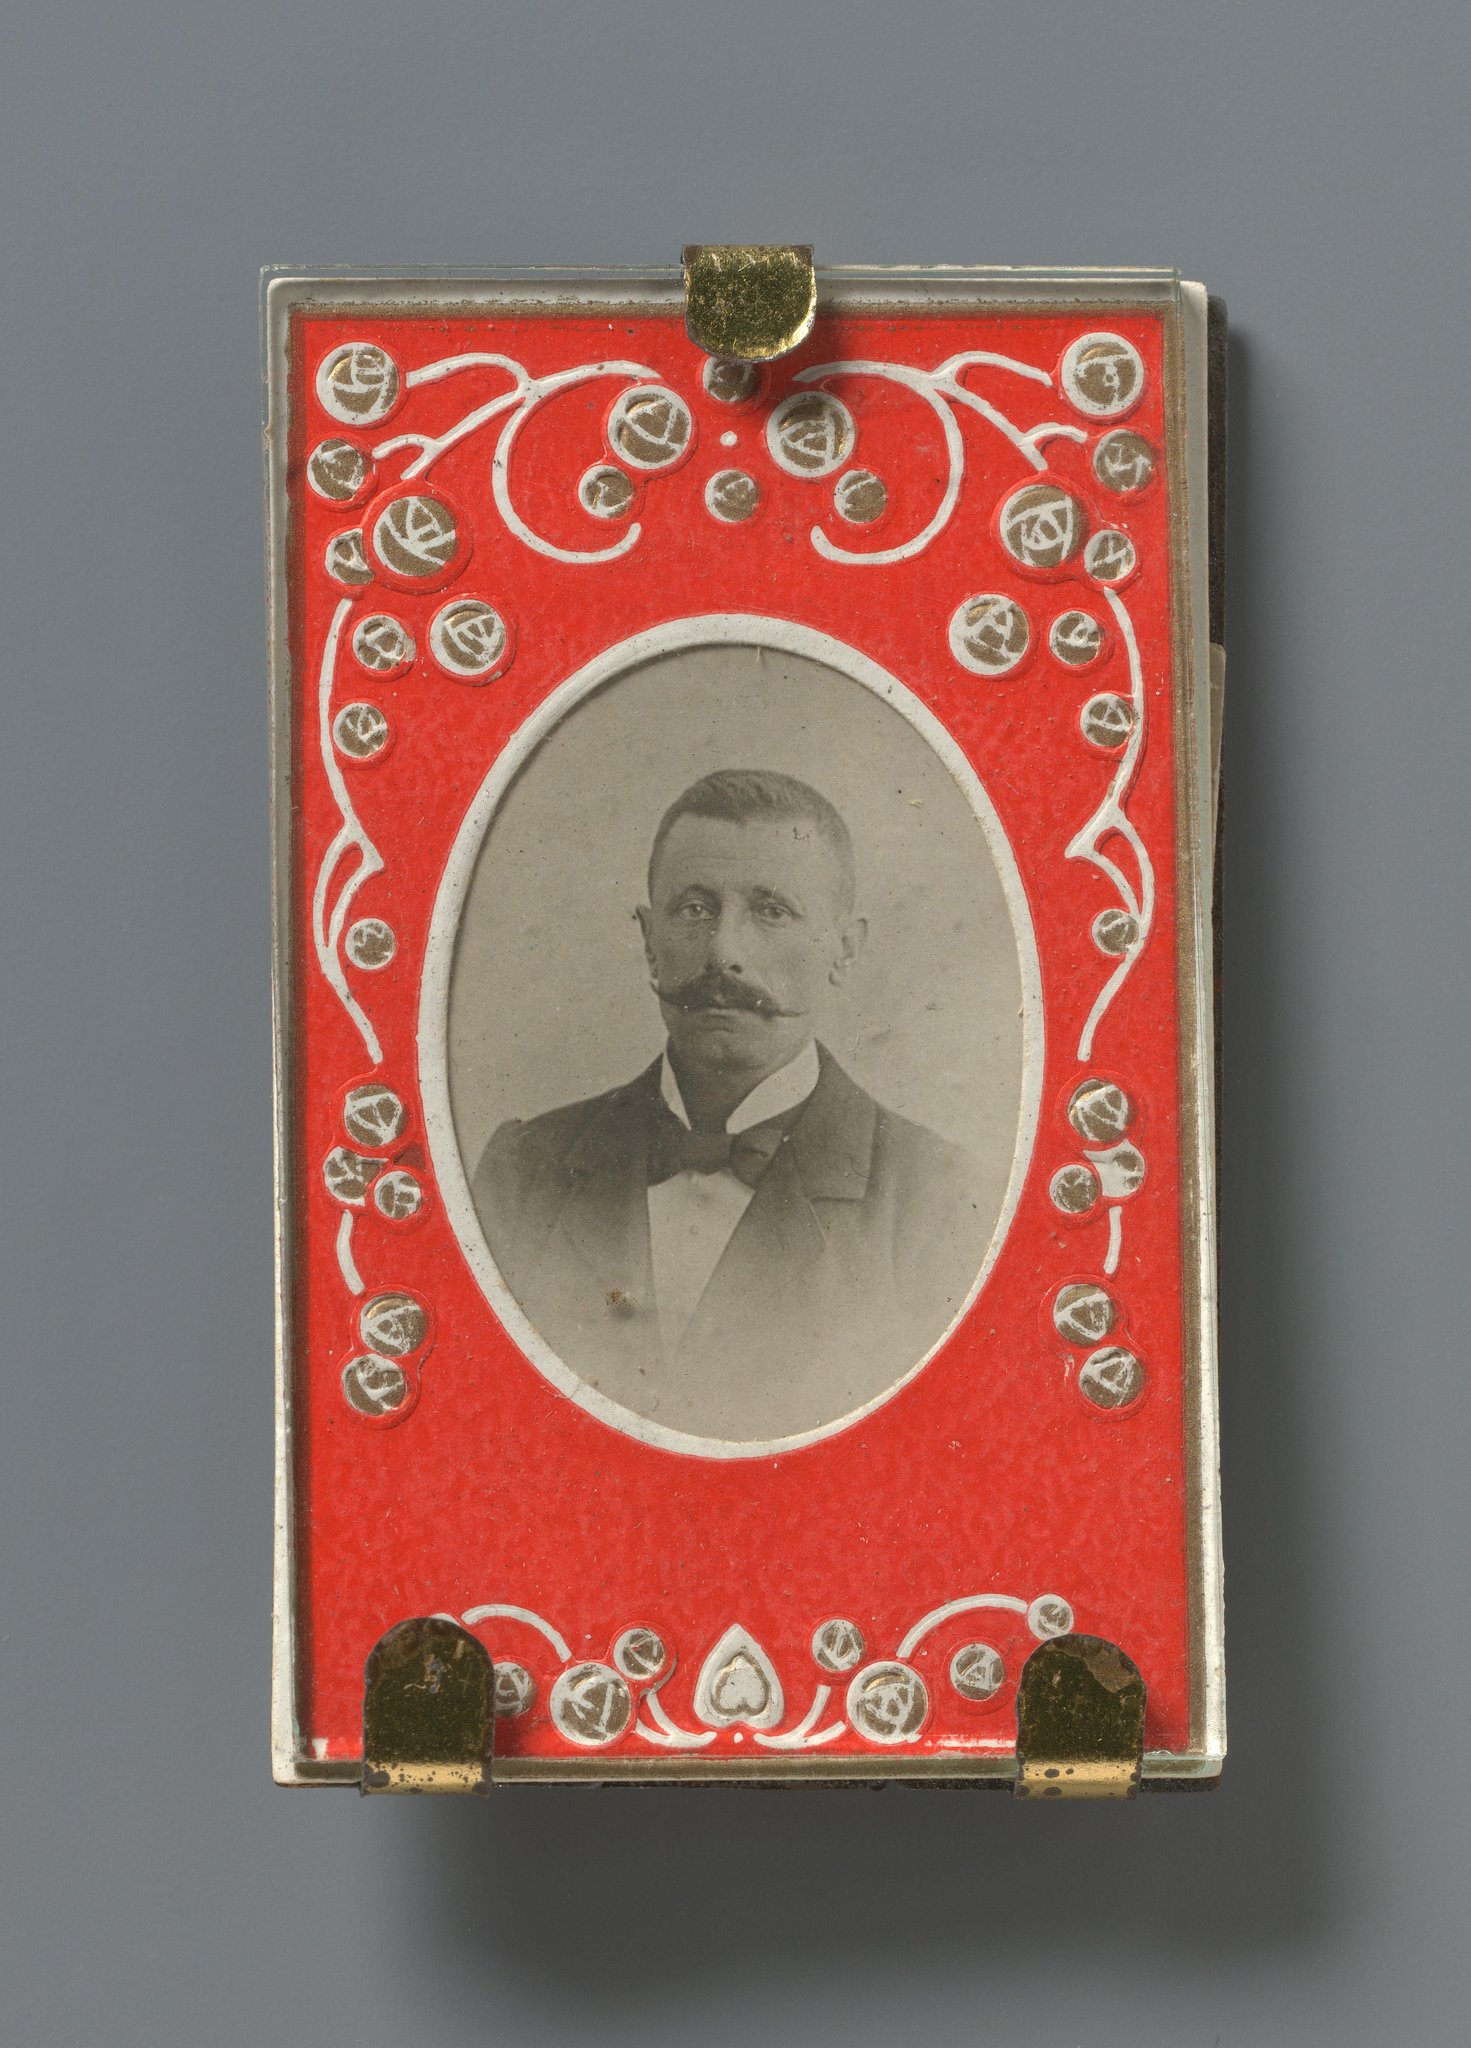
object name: frame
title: Portret van een onbekende man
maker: Anonymous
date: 1900-1920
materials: paper, glass, metal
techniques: gelatin silver print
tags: anonymous historical person portrayed